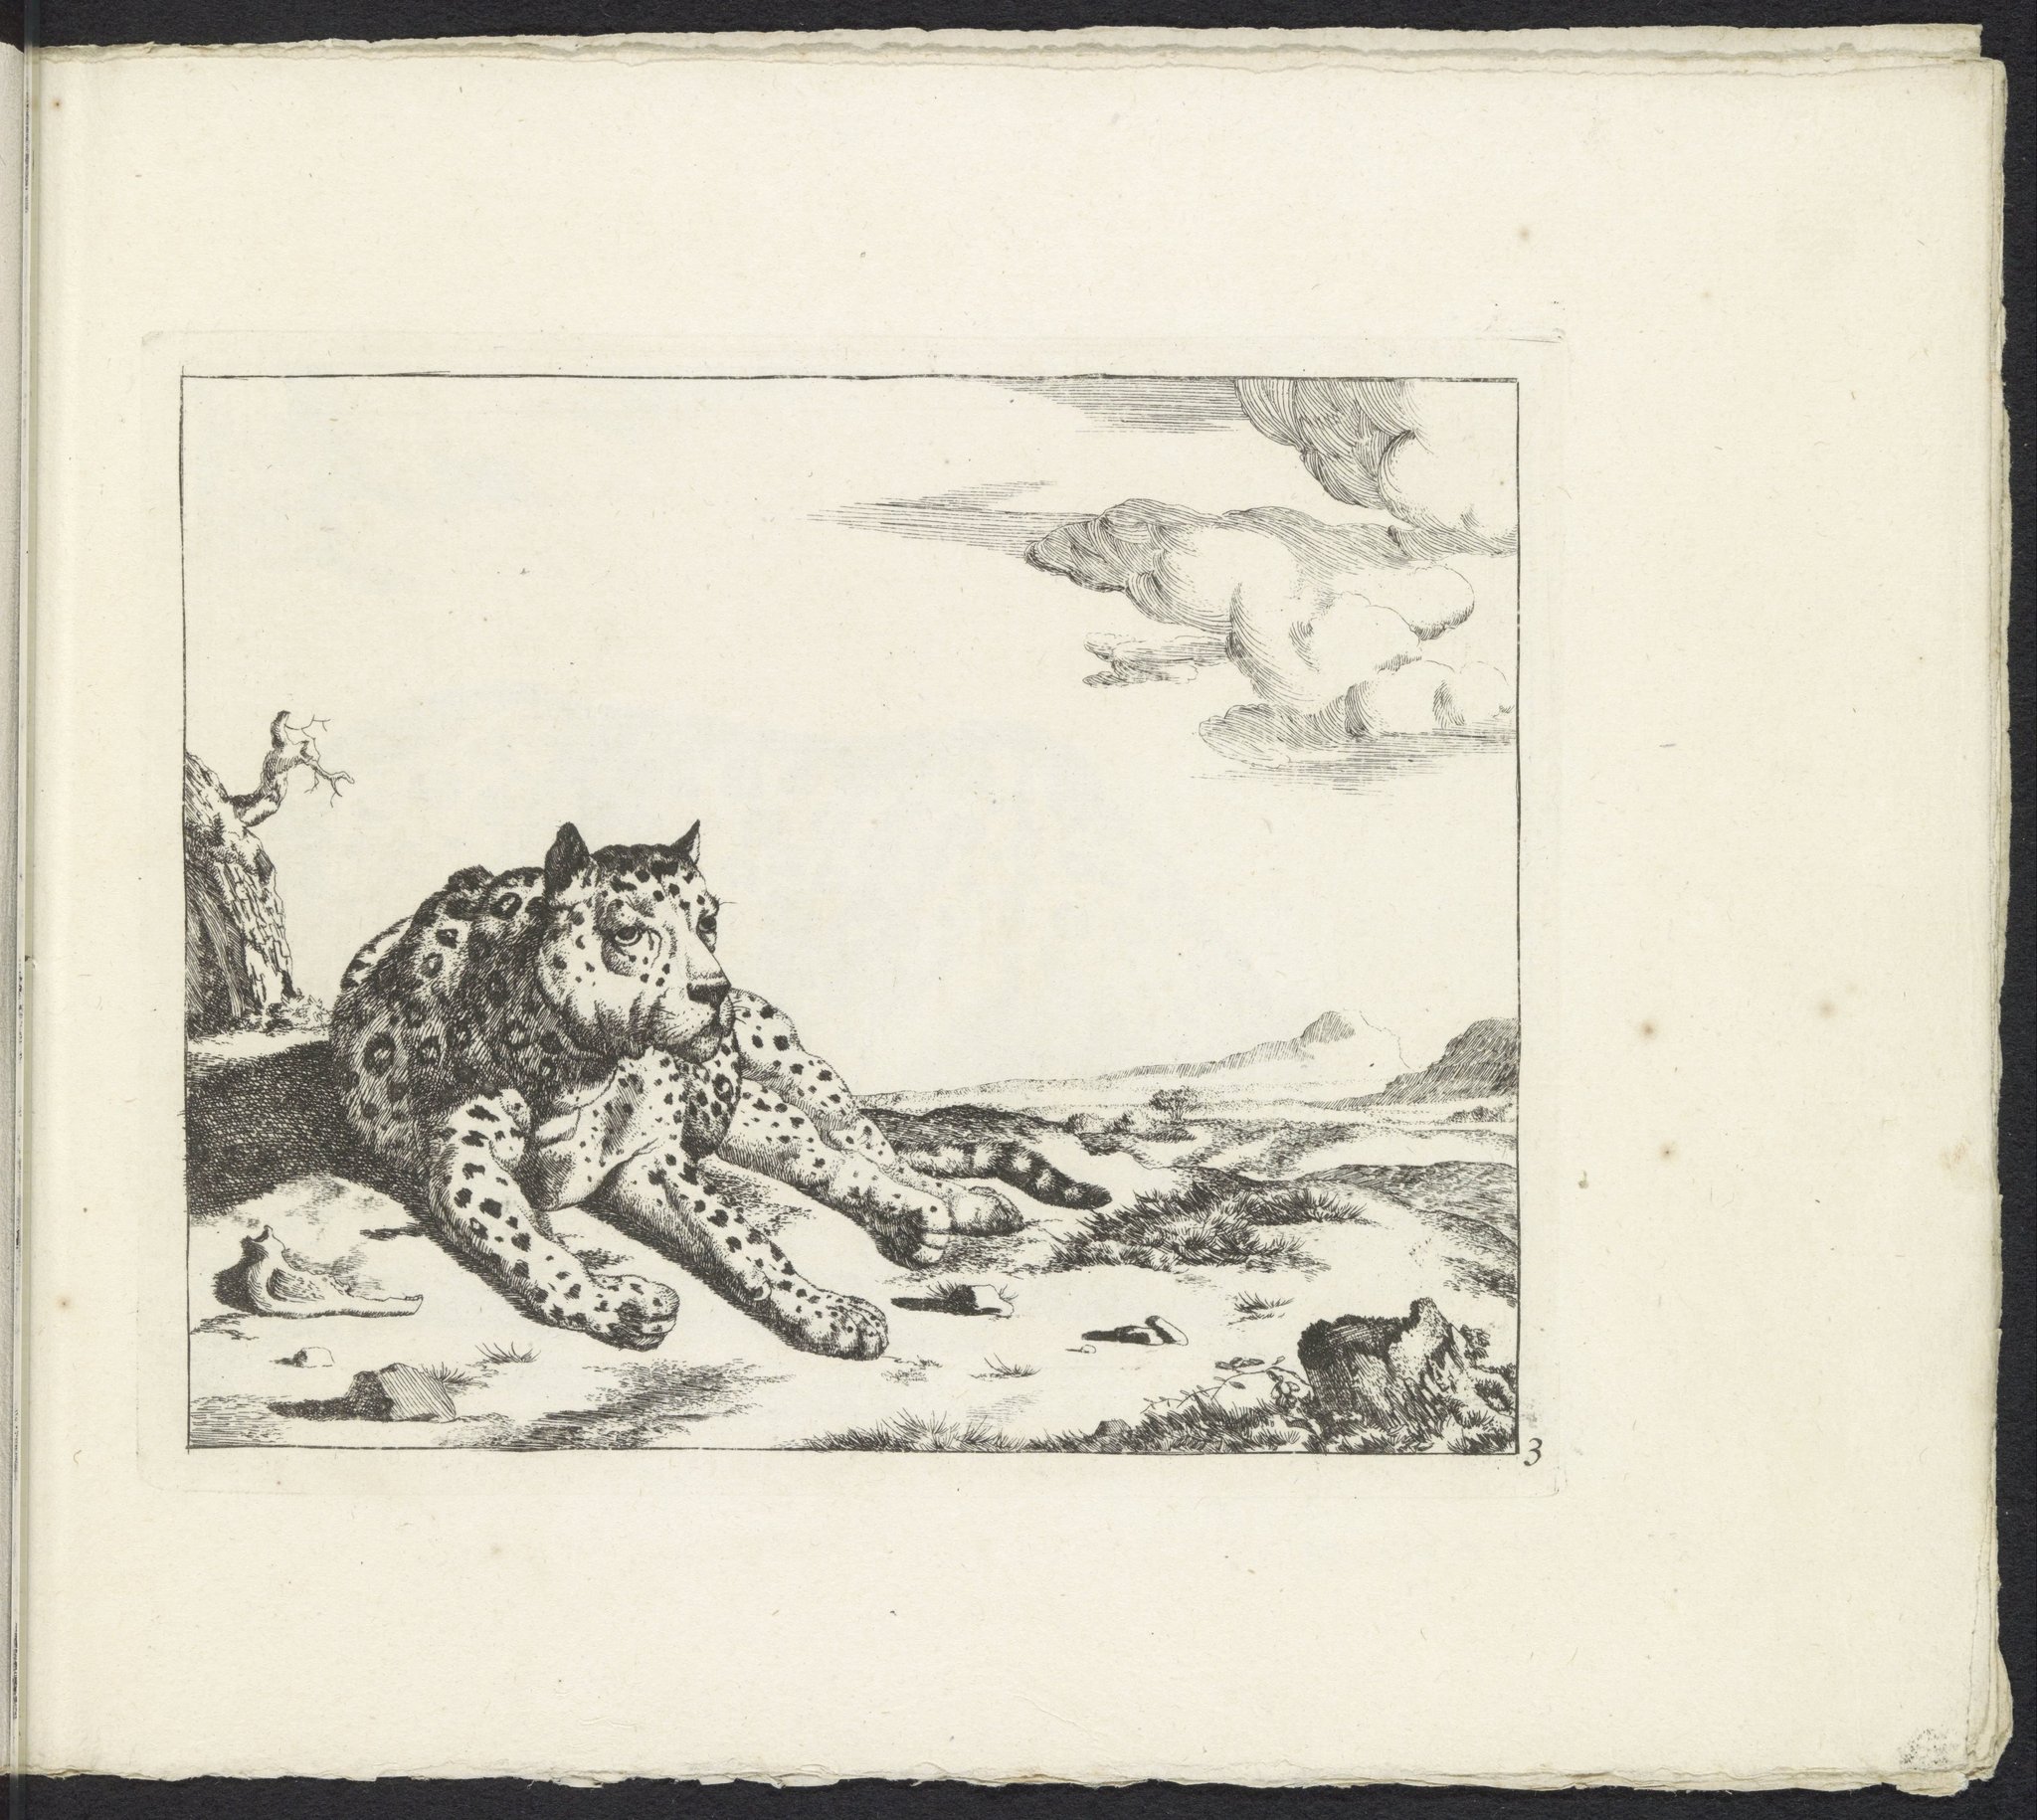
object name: print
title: Liggend luipaard, van voren gezien, de poten naar rechts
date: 1657-1677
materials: paper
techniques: etching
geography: northern netherlands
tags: beasts of prey, predatory animals: leopard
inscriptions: collector's mark: Lugt 2228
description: Liggend luipaard, van voren gezien, de poten naar rechts. Prent uit een serie van acht genummerde prenten met ''naar het leven'' getekende luipaarden, de reeks aan bindtouw.